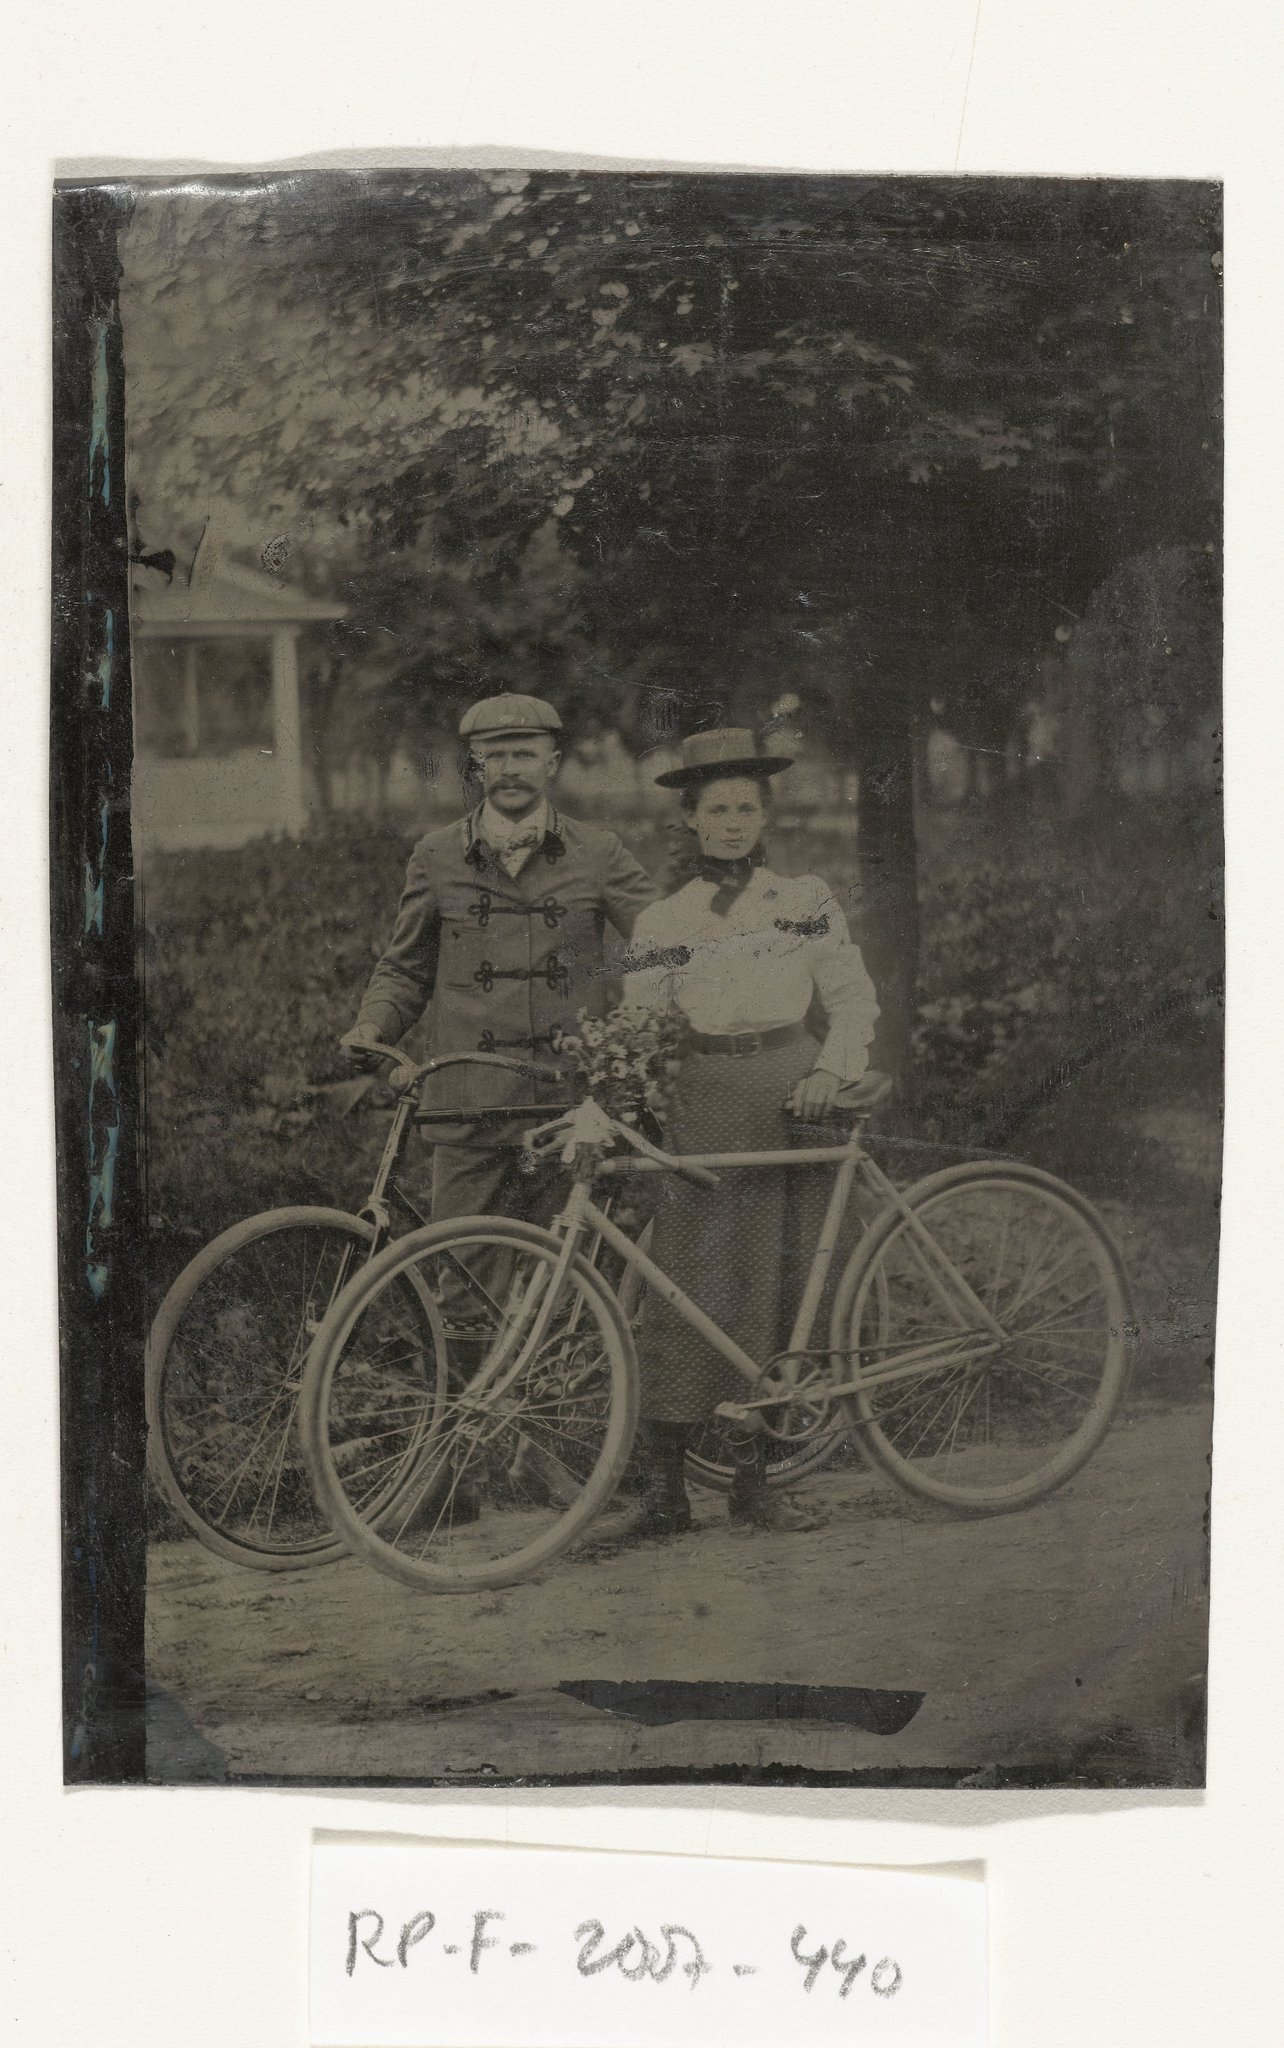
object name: photograph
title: Een man en vrouw staand bij hun fietsen in de openlucht, met een bosje bloemen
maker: Anonymous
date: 1890-1910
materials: metal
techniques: ferrotyping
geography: united states